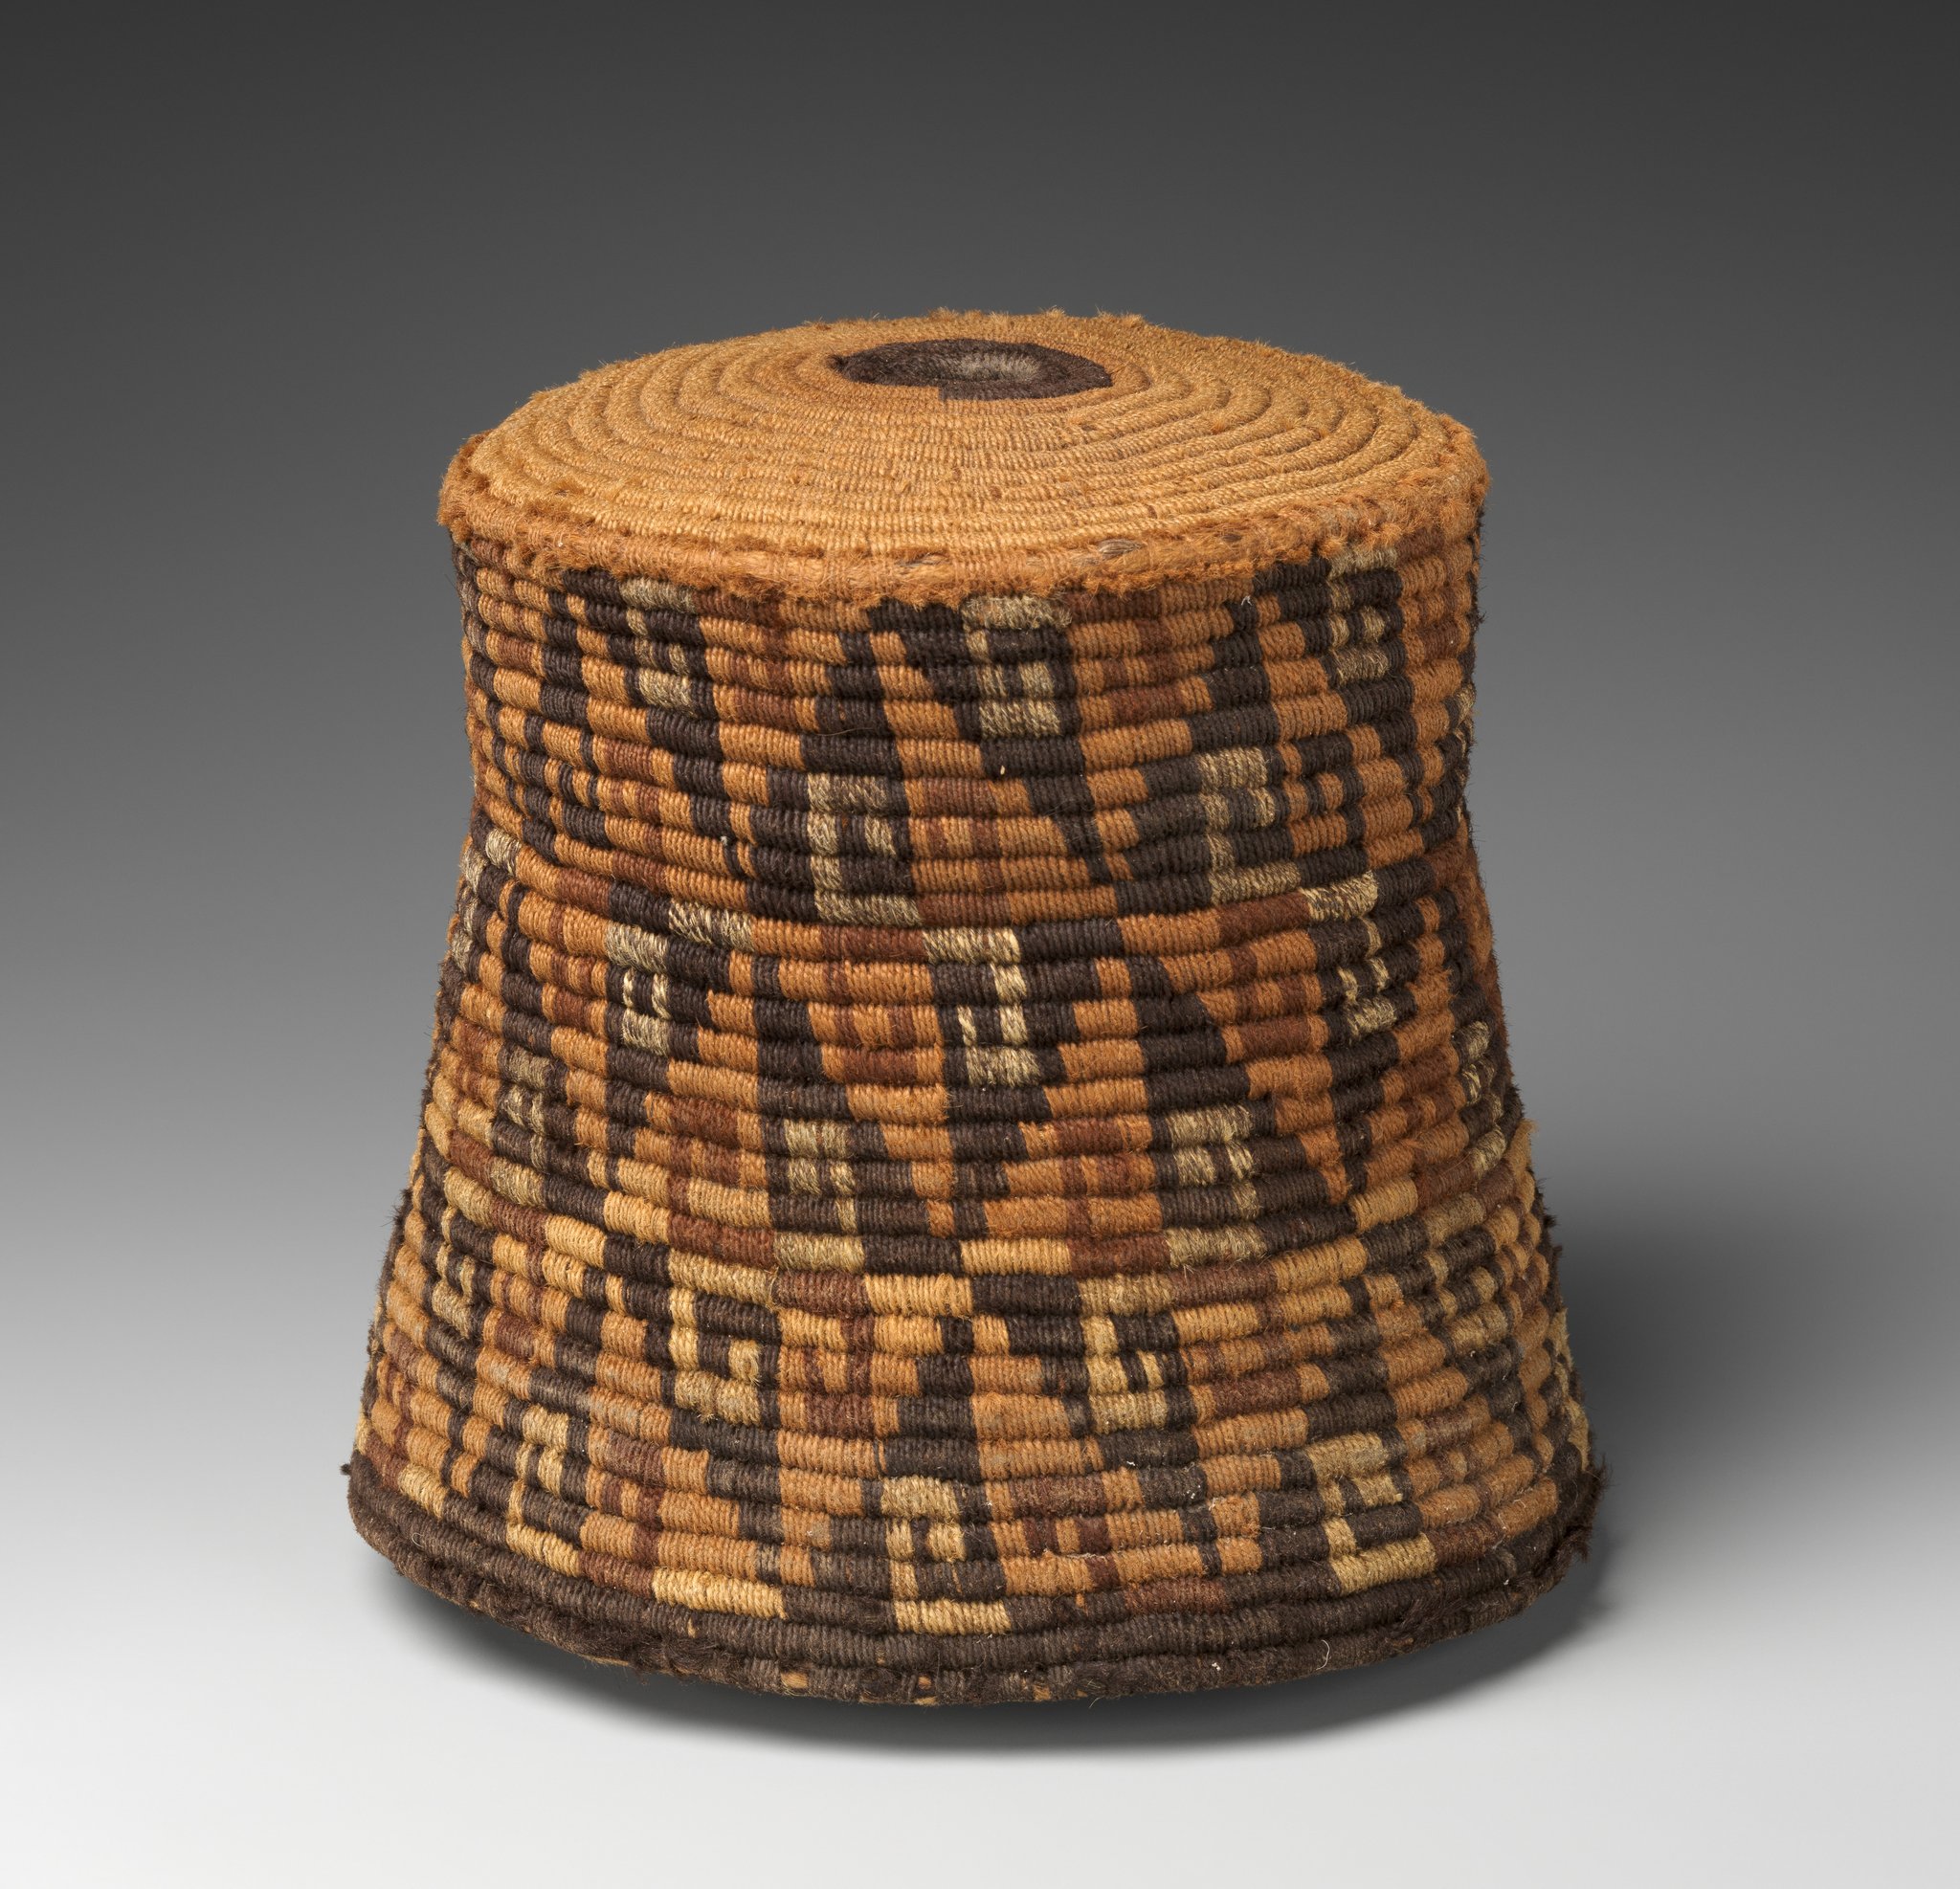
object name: hat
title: Cap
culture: arica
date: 901-1400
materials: animal fiber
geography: chile